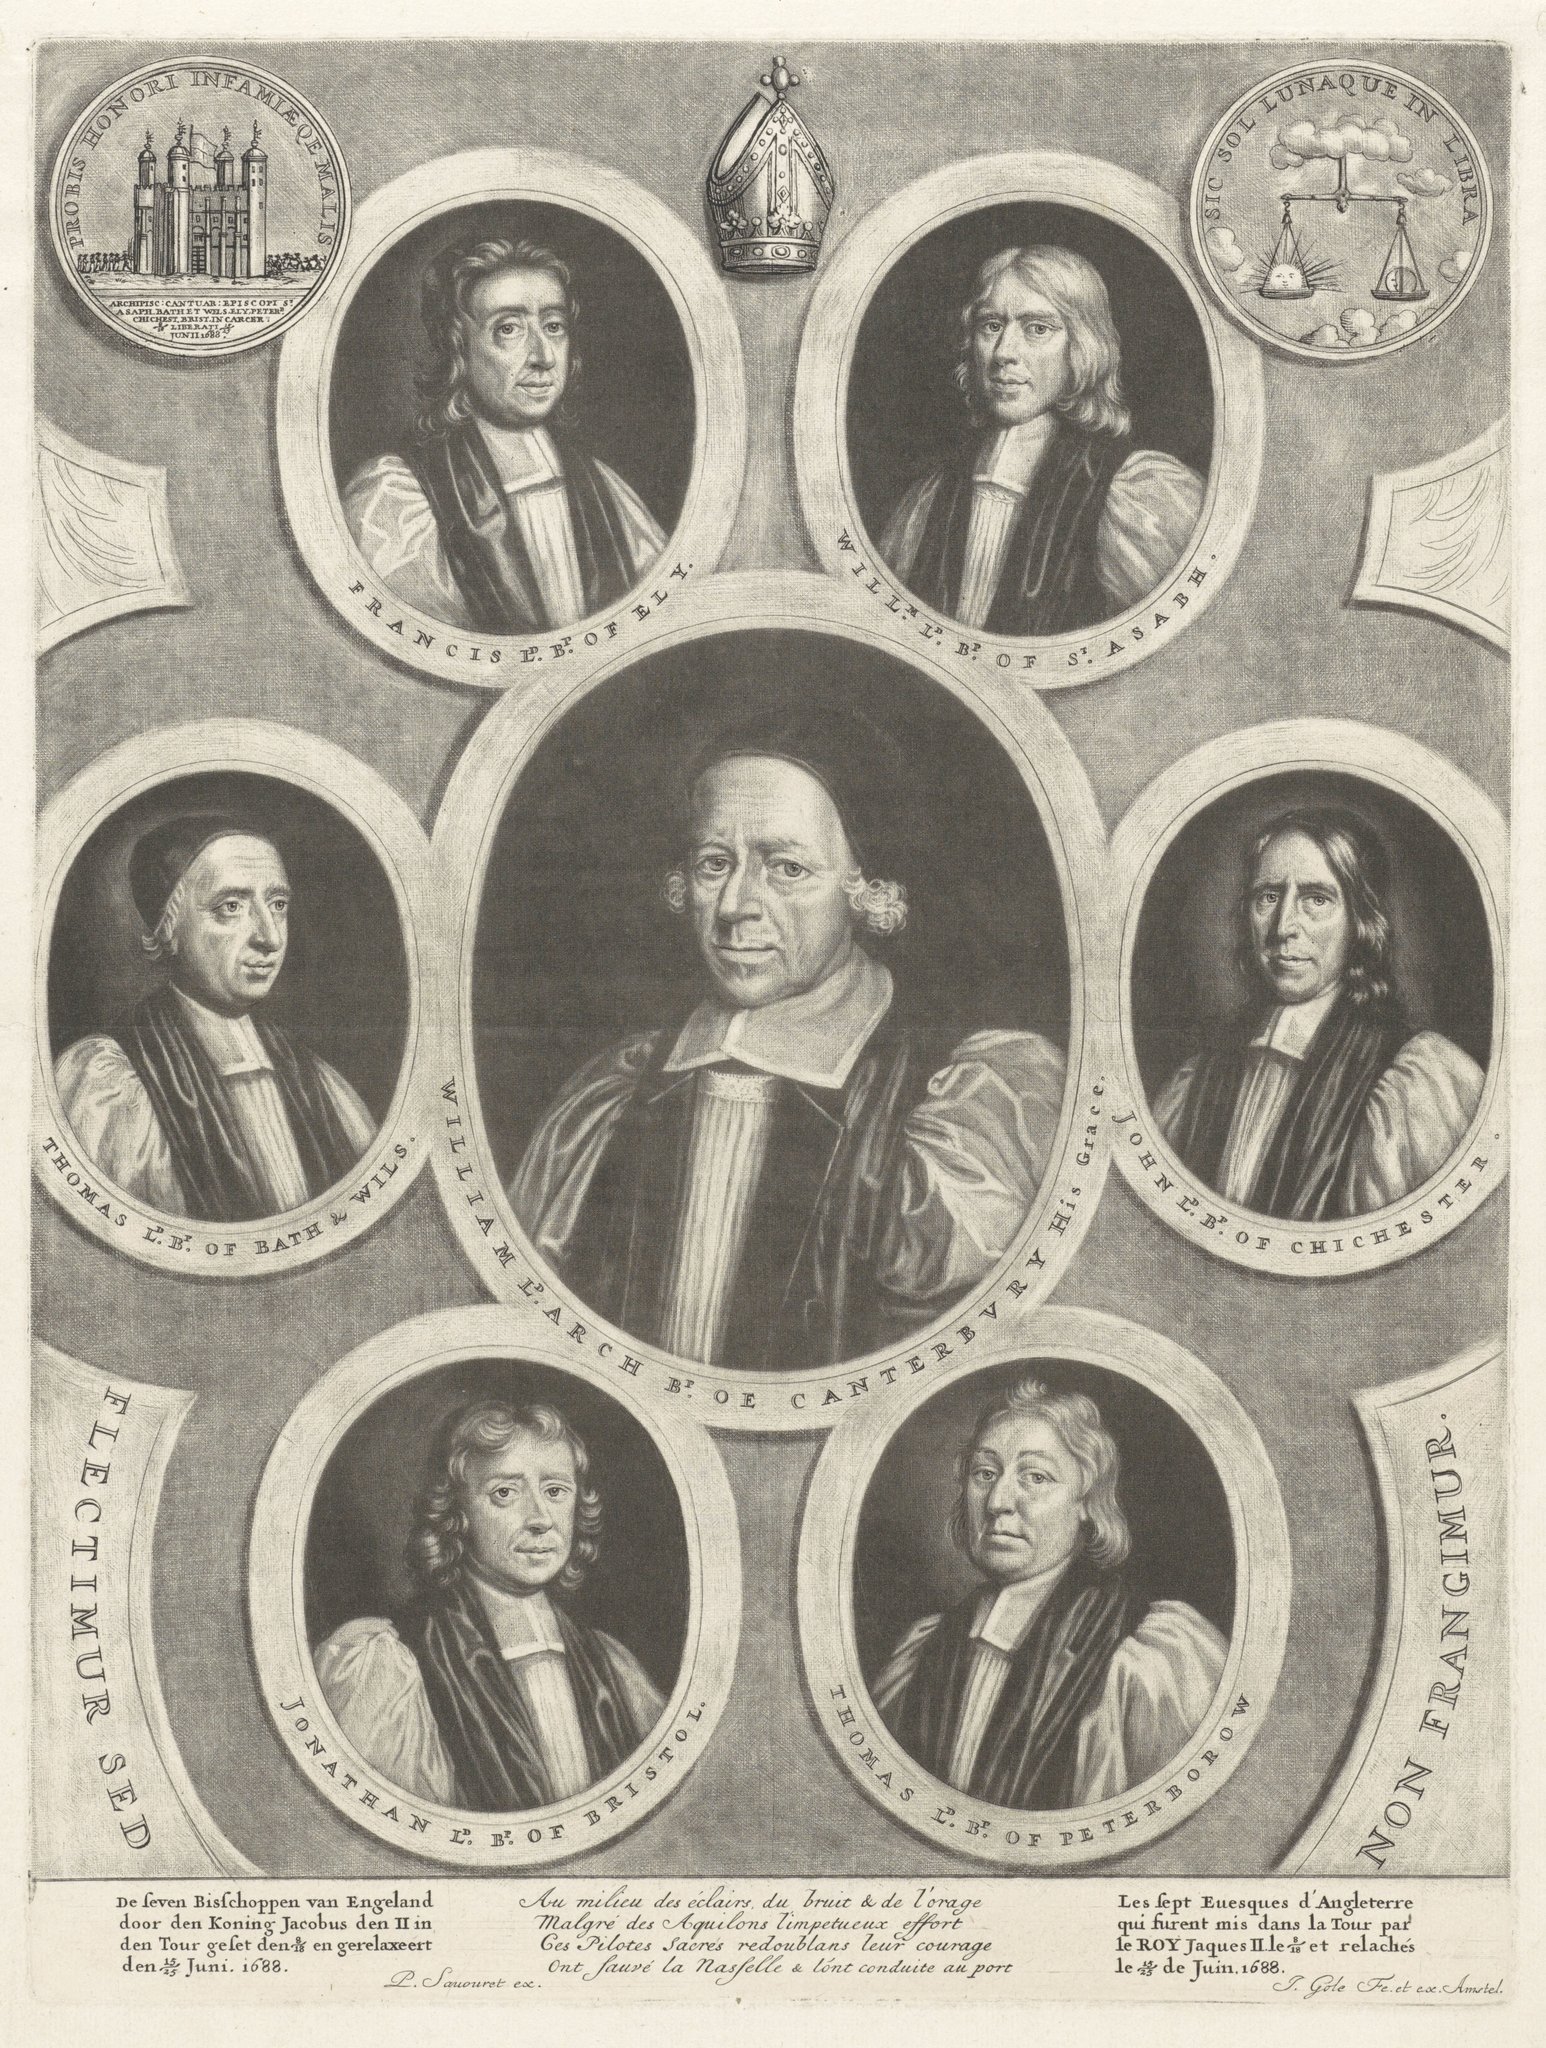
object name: print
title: Portretten van zeven bisschoppen van Engeland, 1688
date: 1688-1693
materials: paper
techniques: engraving, etching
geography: amsterdam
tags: jacobus ii (koning van engeland en schotland), london, archbishop, bishop, etc. (roman catholic), scales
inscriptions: collector's mark: Lugt 2228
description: De zeven bisschoppen van Engeland, die in 1688 door koning Jacobus II in de Tower gezet werden, omdat zij zich openlijk afkeerden van zijn Declaration of Indulgence. In het midden het portret van de aartsbisschop William of Canterbury, daaromheen de portretten van William of St. Asaph, John of Chichester, Thomas of Peterborow, Jonathan of Bristol, Thomas of Bath and Wells and Francis of Ely. Bovenaan twee medaillons: een toont een afbeelding van de Tower, de ander een afbeelding van een weegschaal met een zon en een maan.